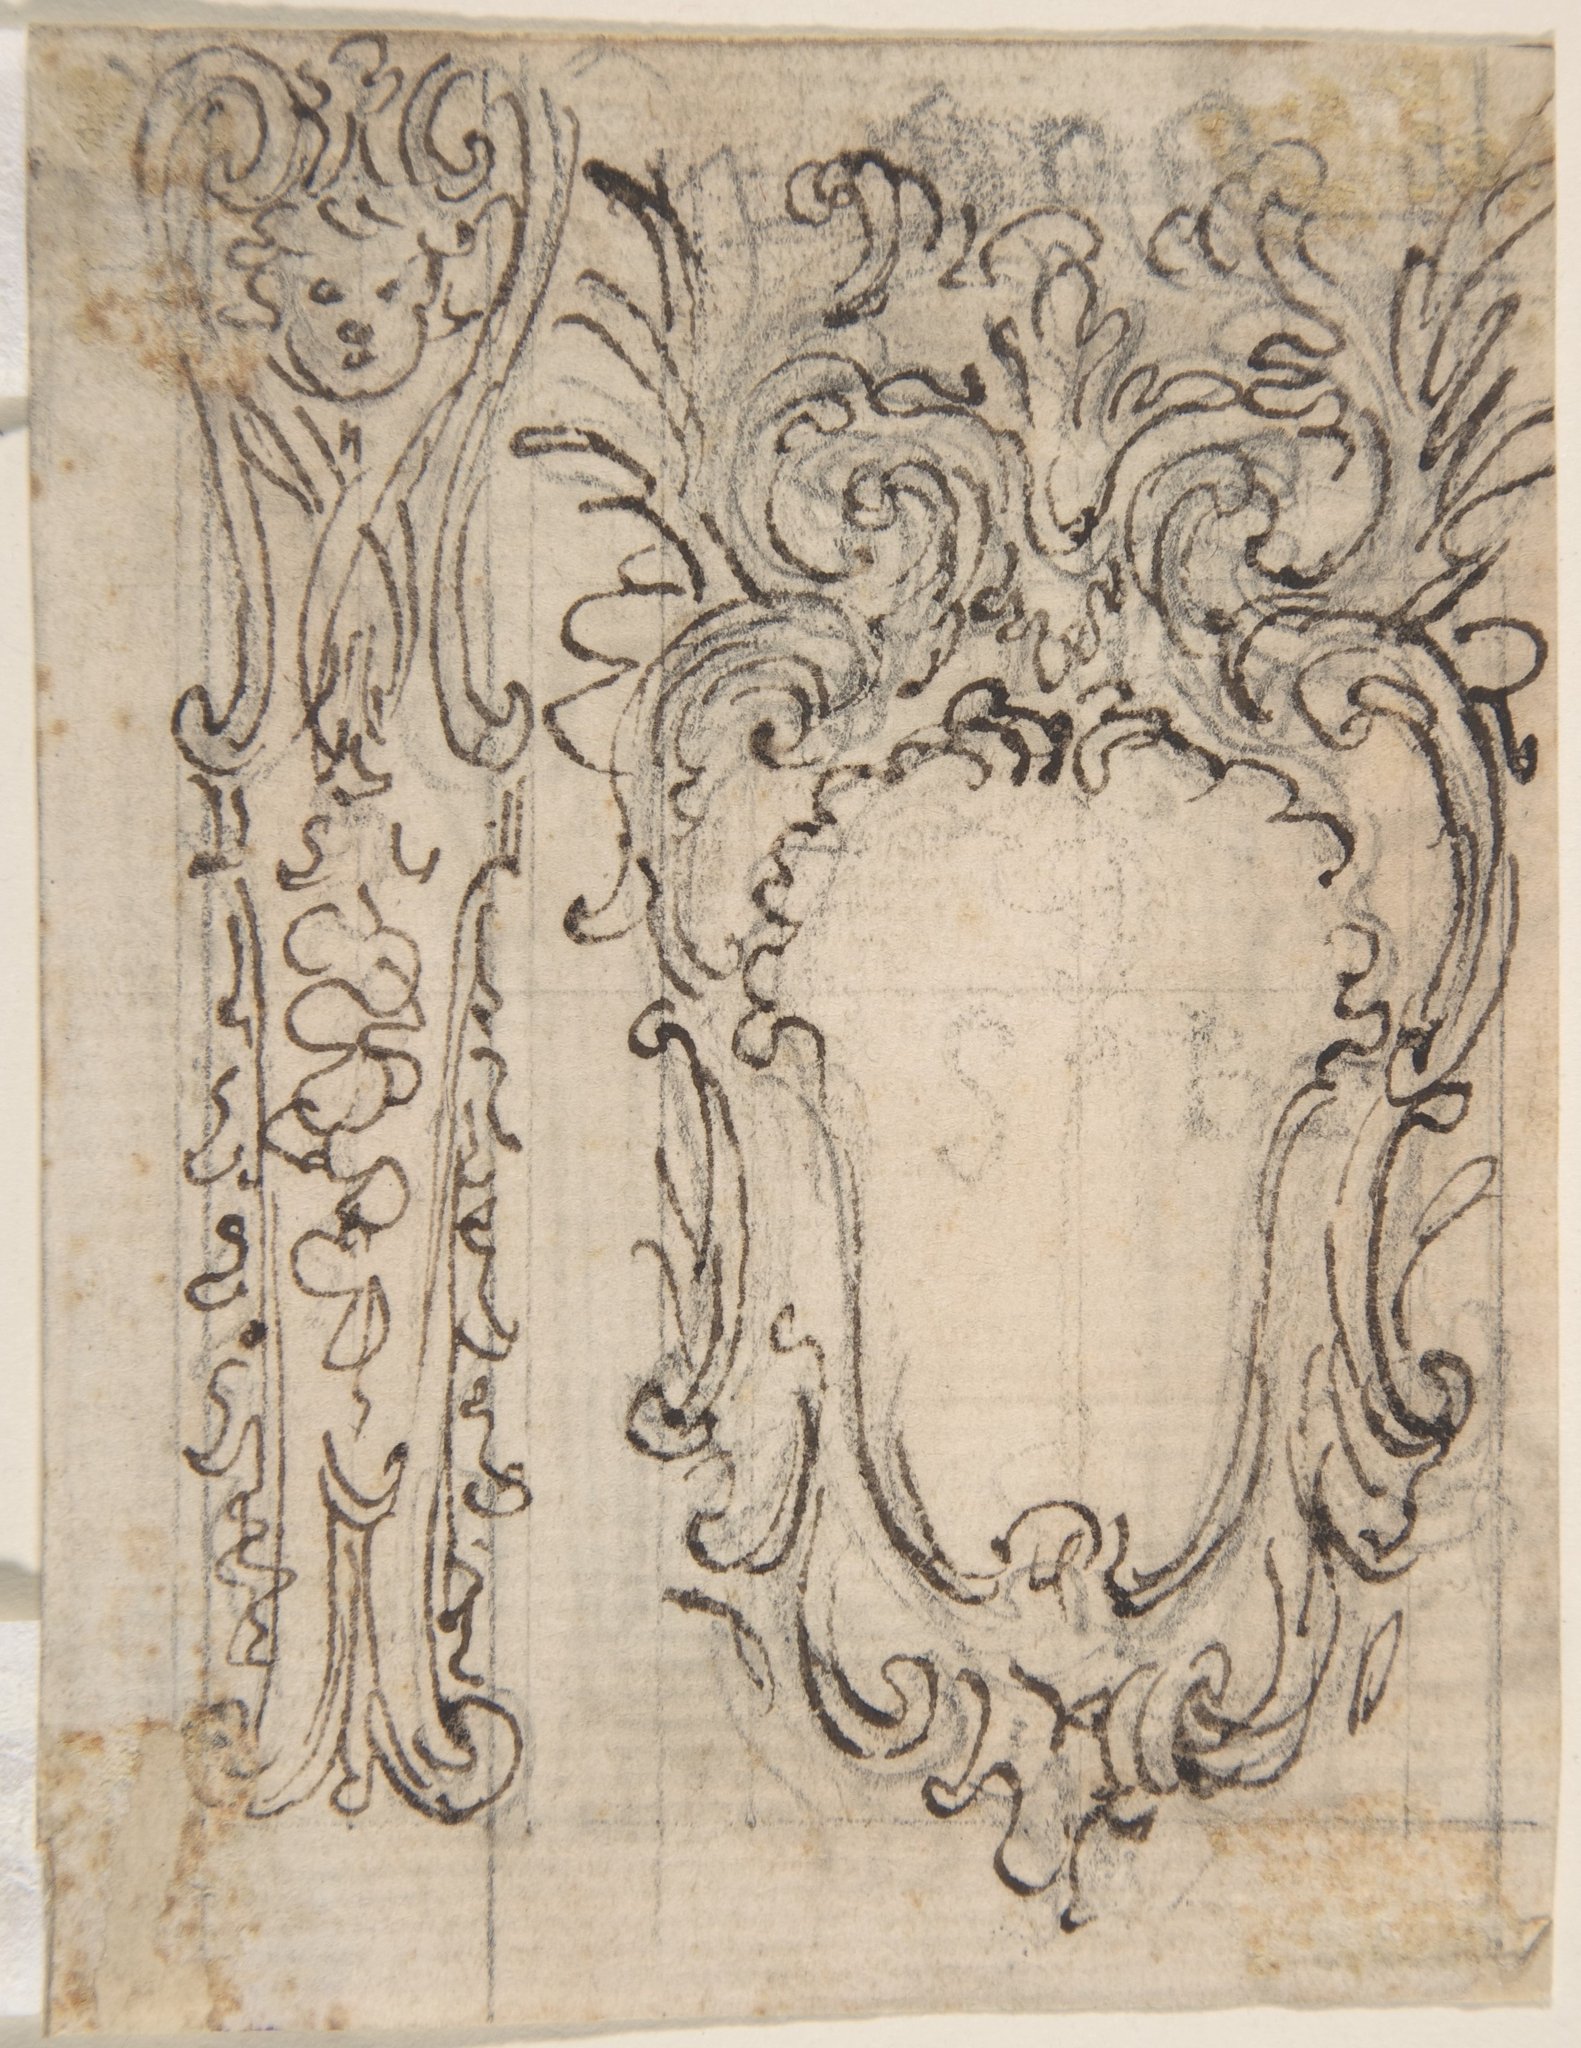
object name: drawing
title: Designs for a Pilaster Ornament and Cartouche (recto); Design for a Window or a Wall Plaque (verso)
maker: giovanni battista foggini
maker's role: artist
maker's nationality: italian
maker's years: 1652-1725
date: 1672-1725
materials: chalk, ink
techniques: pen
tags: cartouches,ornament